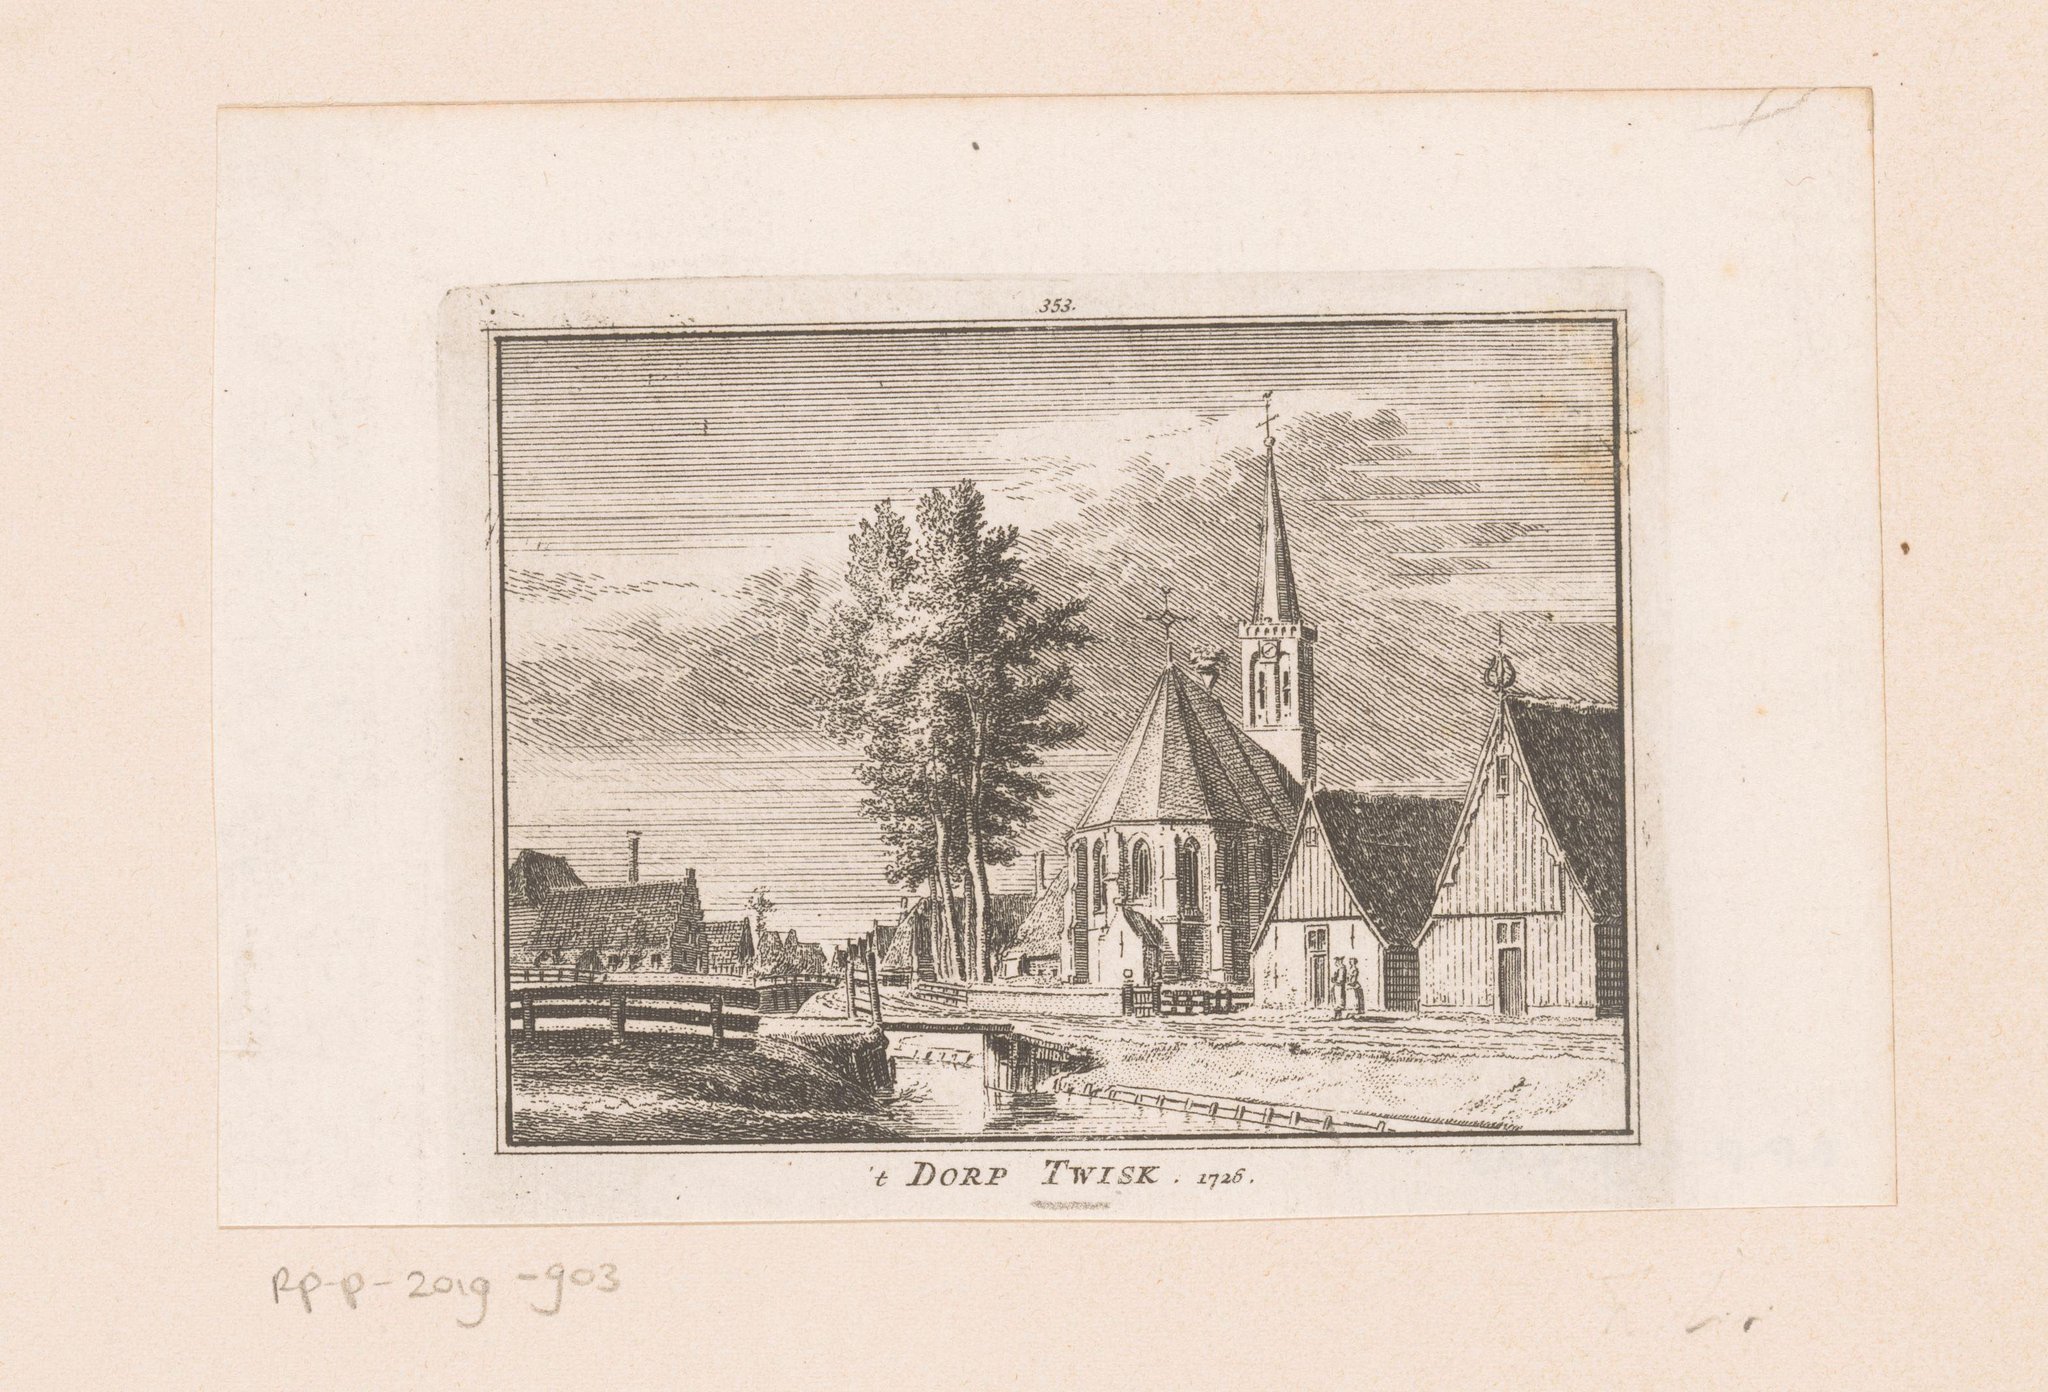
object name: print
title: Gezicht op Twisk, 1726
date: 1745-1774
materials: paper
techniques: etching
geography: amsterdam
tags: the christian churches, prospect of village, silhouette of village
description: Prent verschenen in: Het verheerlykt Nederland of kabinet van hedendaagsche gezigten. Amsterdam: Isaac Tirion, 1745-1774.